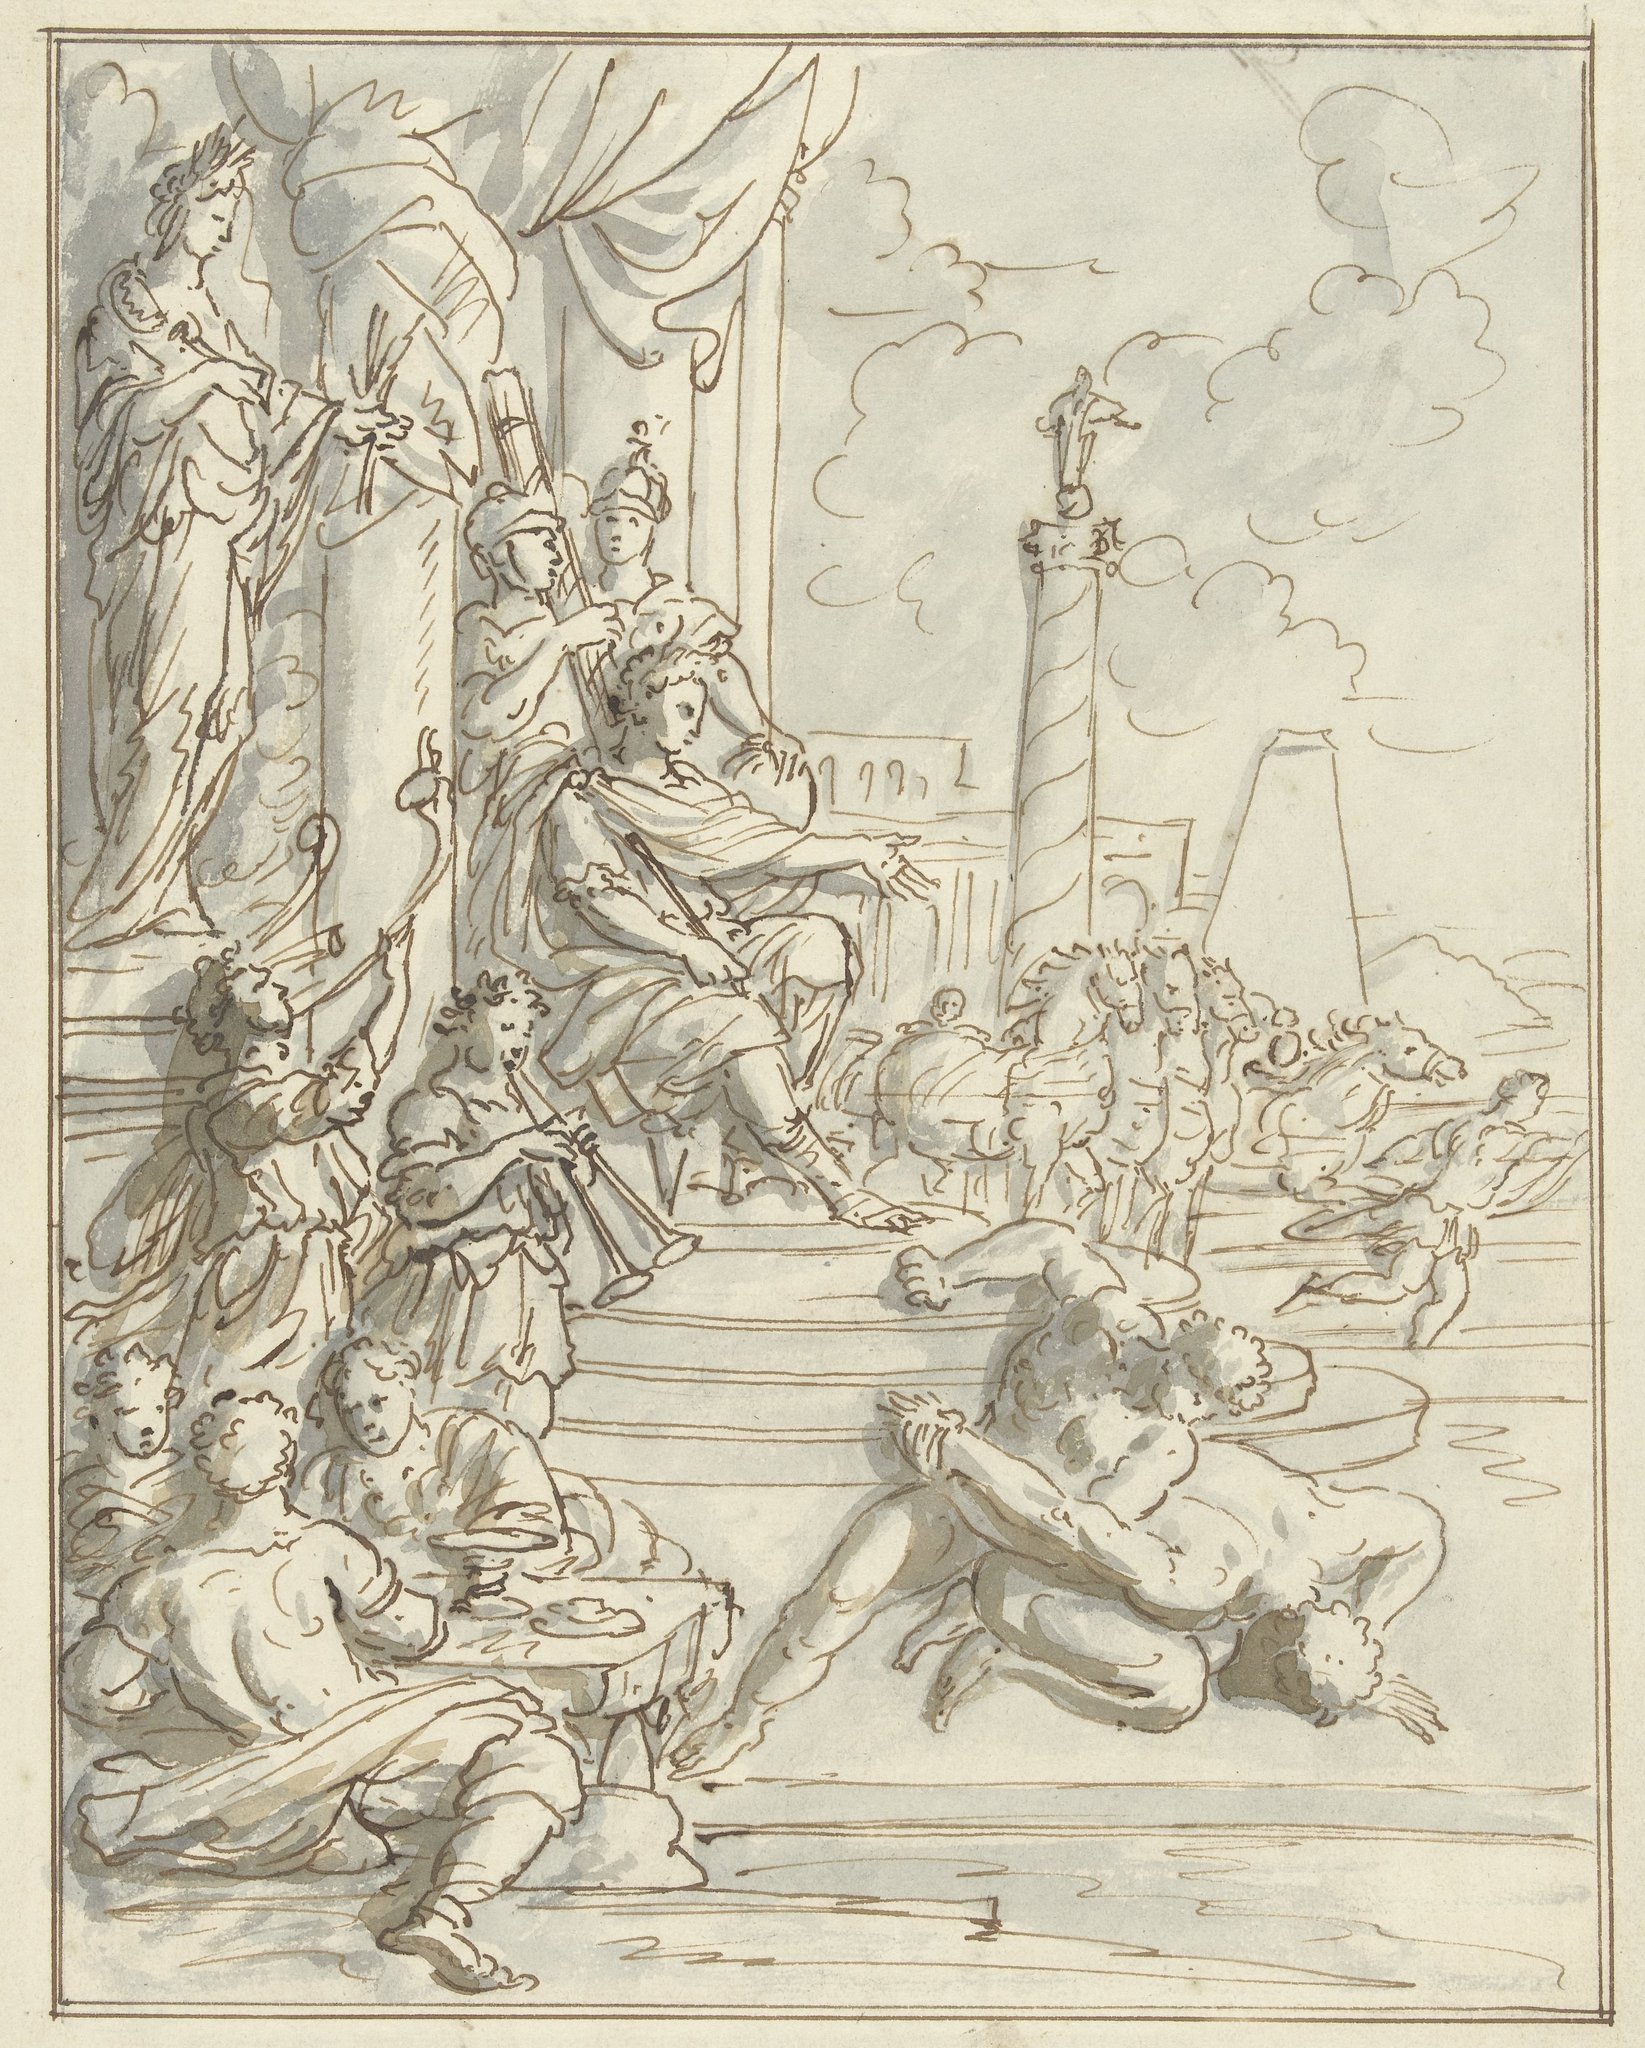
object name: design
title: Lucius Aemilius Paullus laat te Amphipolis feesten aanrichten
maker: elias van nijmegen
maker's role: draughtsman, painter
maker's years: 1667-1755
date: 1677-1755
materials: ink, paper, pencil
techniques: brush, pen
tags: triumph of lucius aemilius paul(l)us